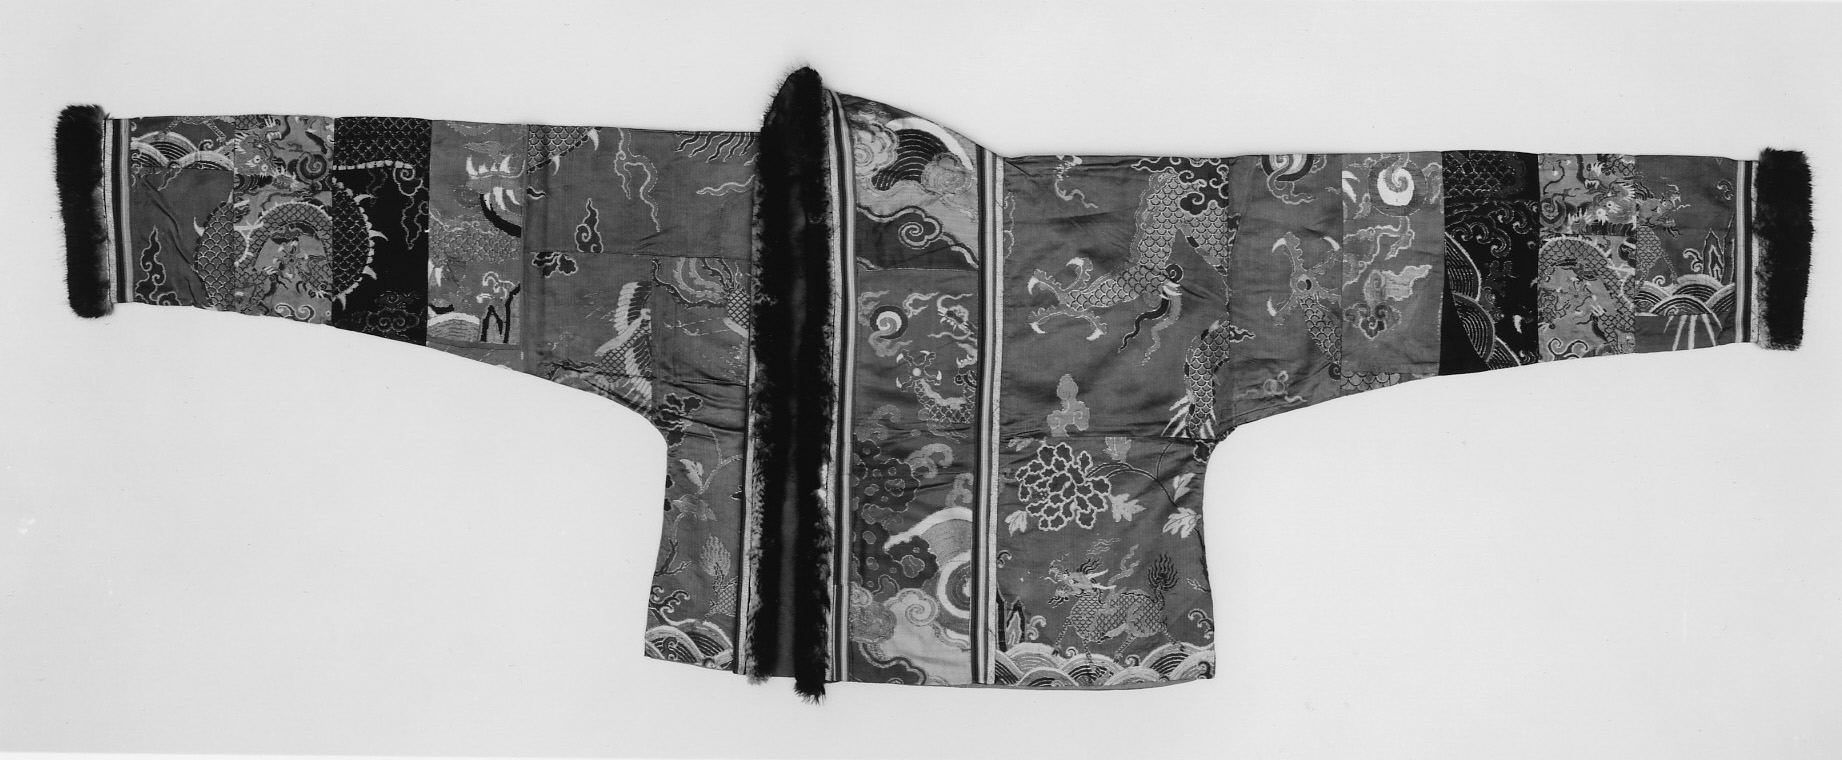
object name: jacket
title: Lay Aristocrat Man's Gayluchang Jacket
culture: tibetan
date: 1644-1911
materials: silk